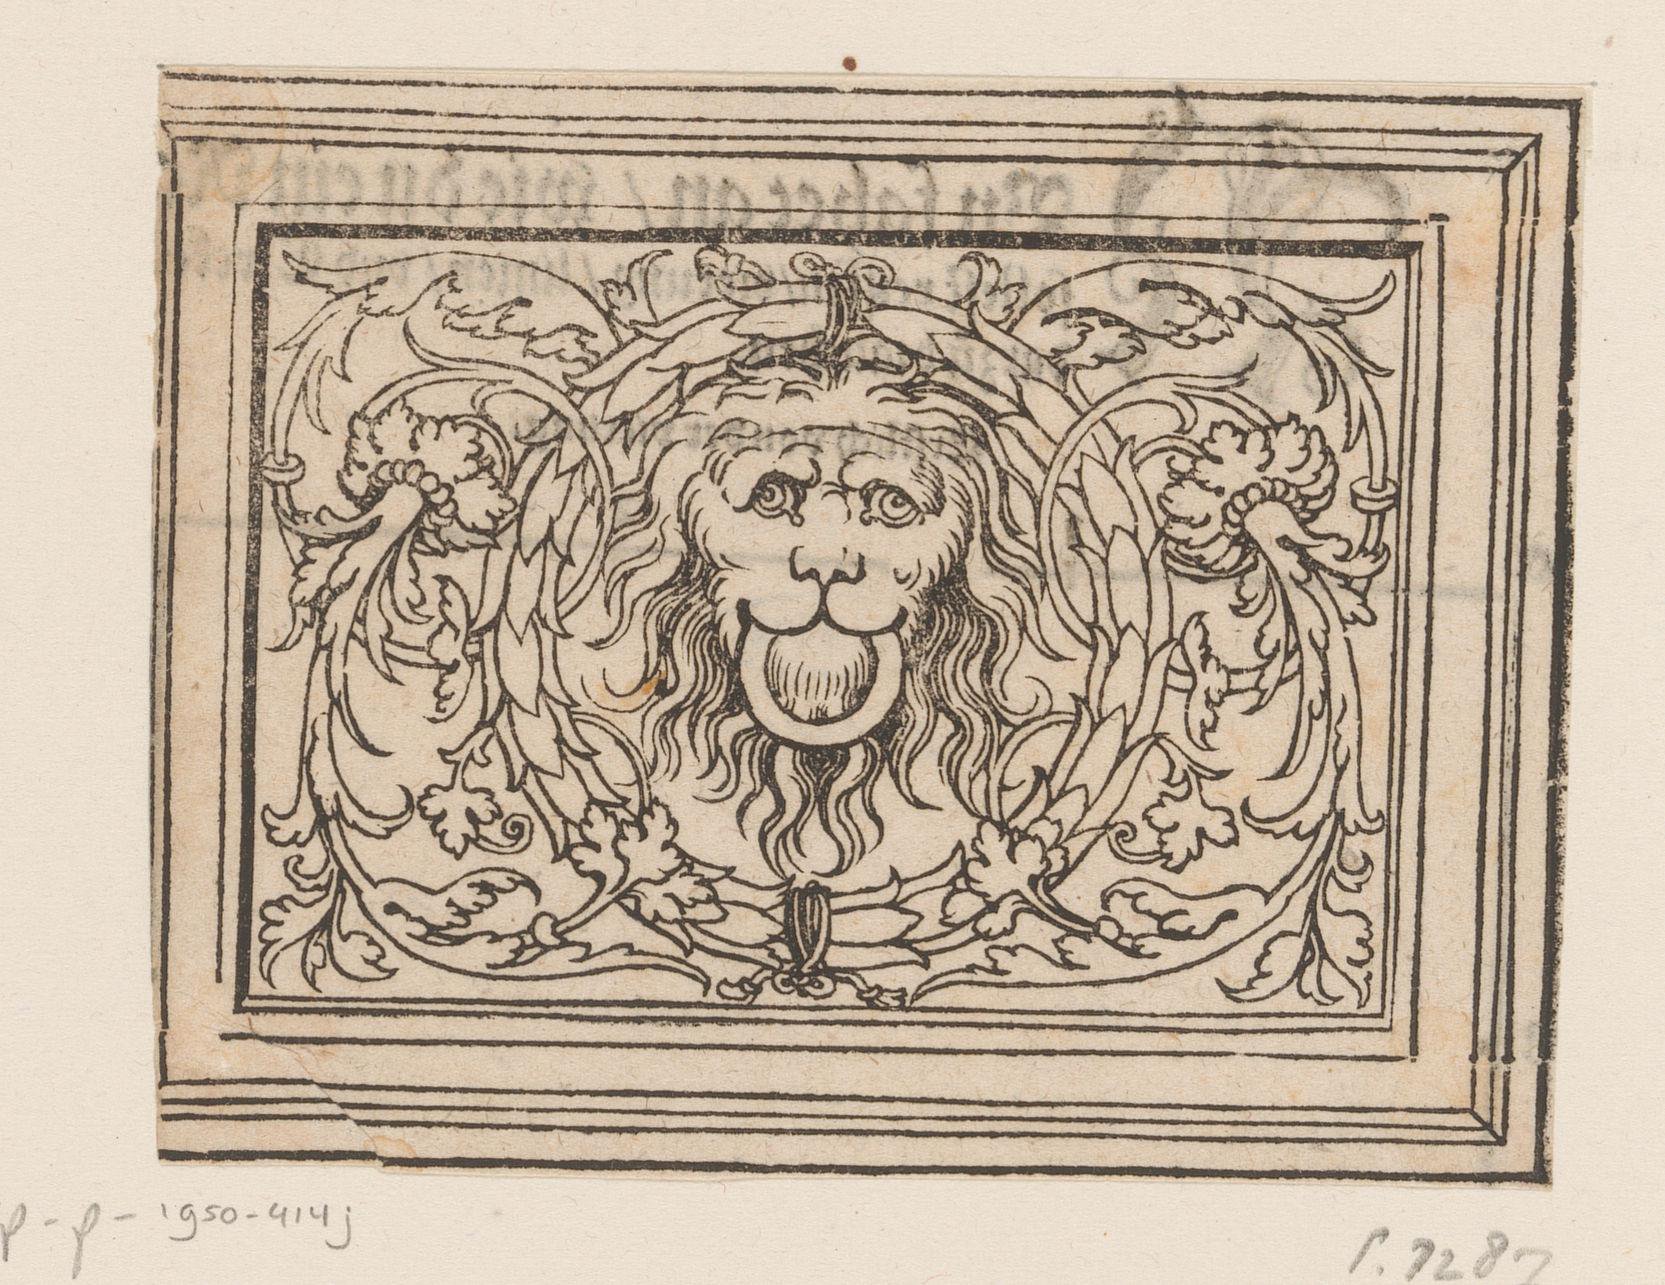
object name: book illustration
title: Model voor een ornament met een leeuwekop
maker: Anonymous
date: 1565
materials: paper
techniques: letterpress printing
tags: lion's head ~ ornament, model-books ~ implements of painter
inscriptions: collector's mark: Lugt 2228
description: Prent afkomstig uit: Beham, Hans Sebald. Sebalden Behems Kunst und Ler Büchlin (...). Frankfurt am Main: erven Christian Egenolff, 1565.